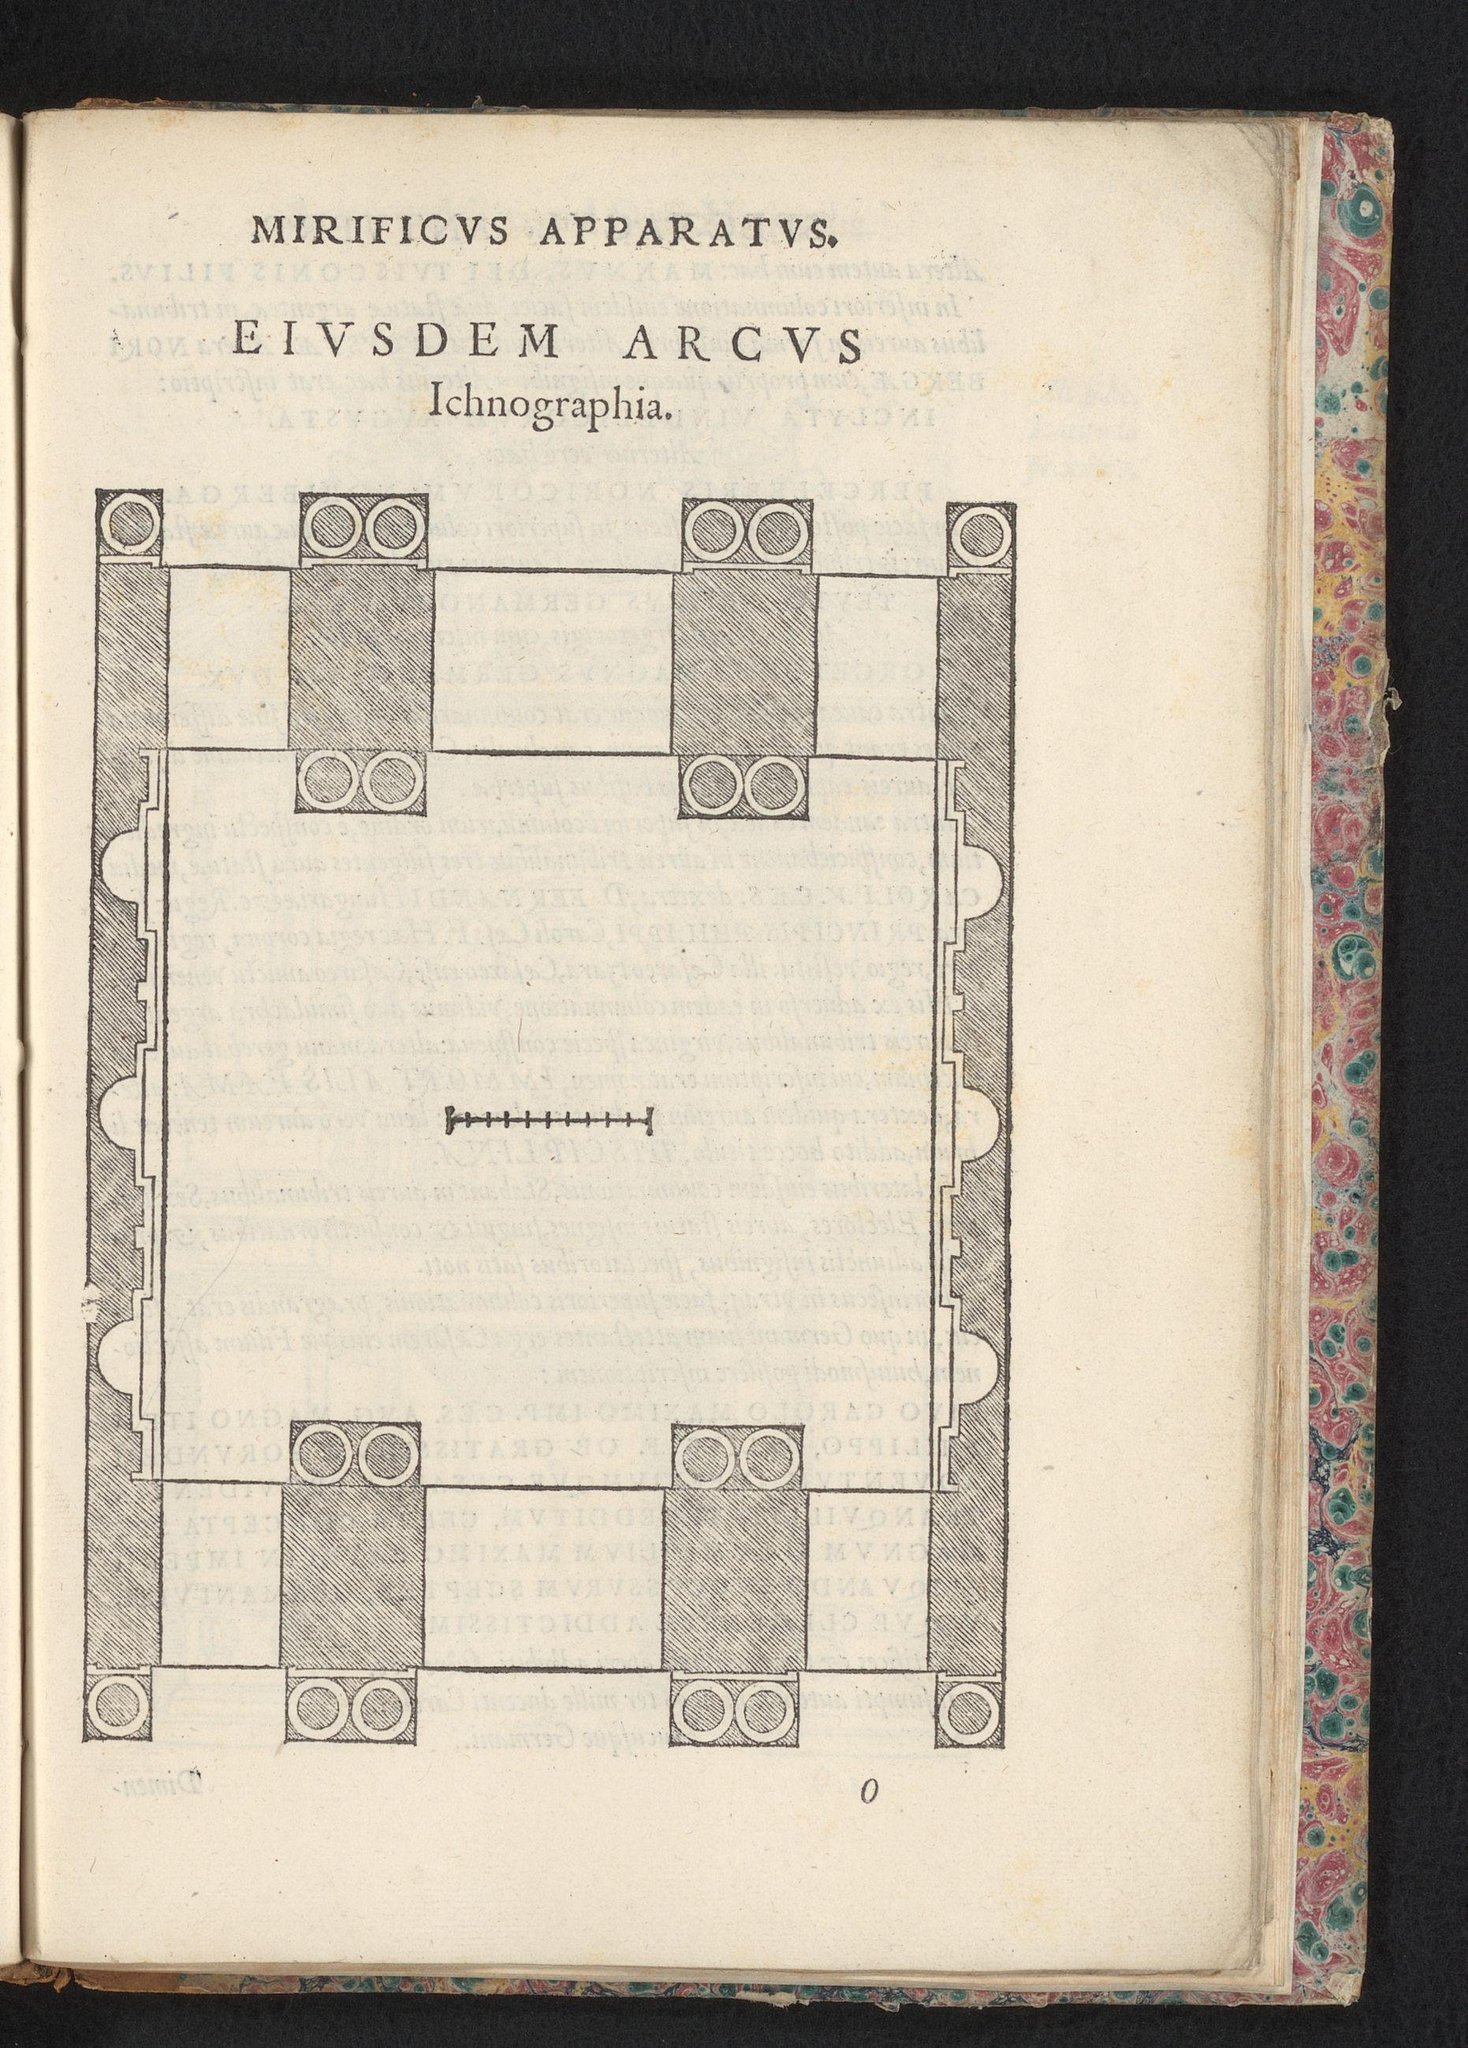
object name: print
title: Eiusdem arcus Ichnographia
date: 1549-1550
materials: paper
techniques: woodcut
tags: philip ii of spain, triumphal arch, antwerp, germany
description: Illustratie in: Spectaculorum in susceptione Philippi Hisp. Prin. Divi Caroli. V. Caes. F. ann 1549 Antverpiae aeditorum, mirificus apparatus. Tekst van Cornelius Grapheus, opgedragen aan Filips II, uitgegeven met keizerlijke privilege door Pieter Coecke van Aelst, gedrukt door Gillis van Diest. Boek in de bibliotheek met signatuur: 325 B 13.